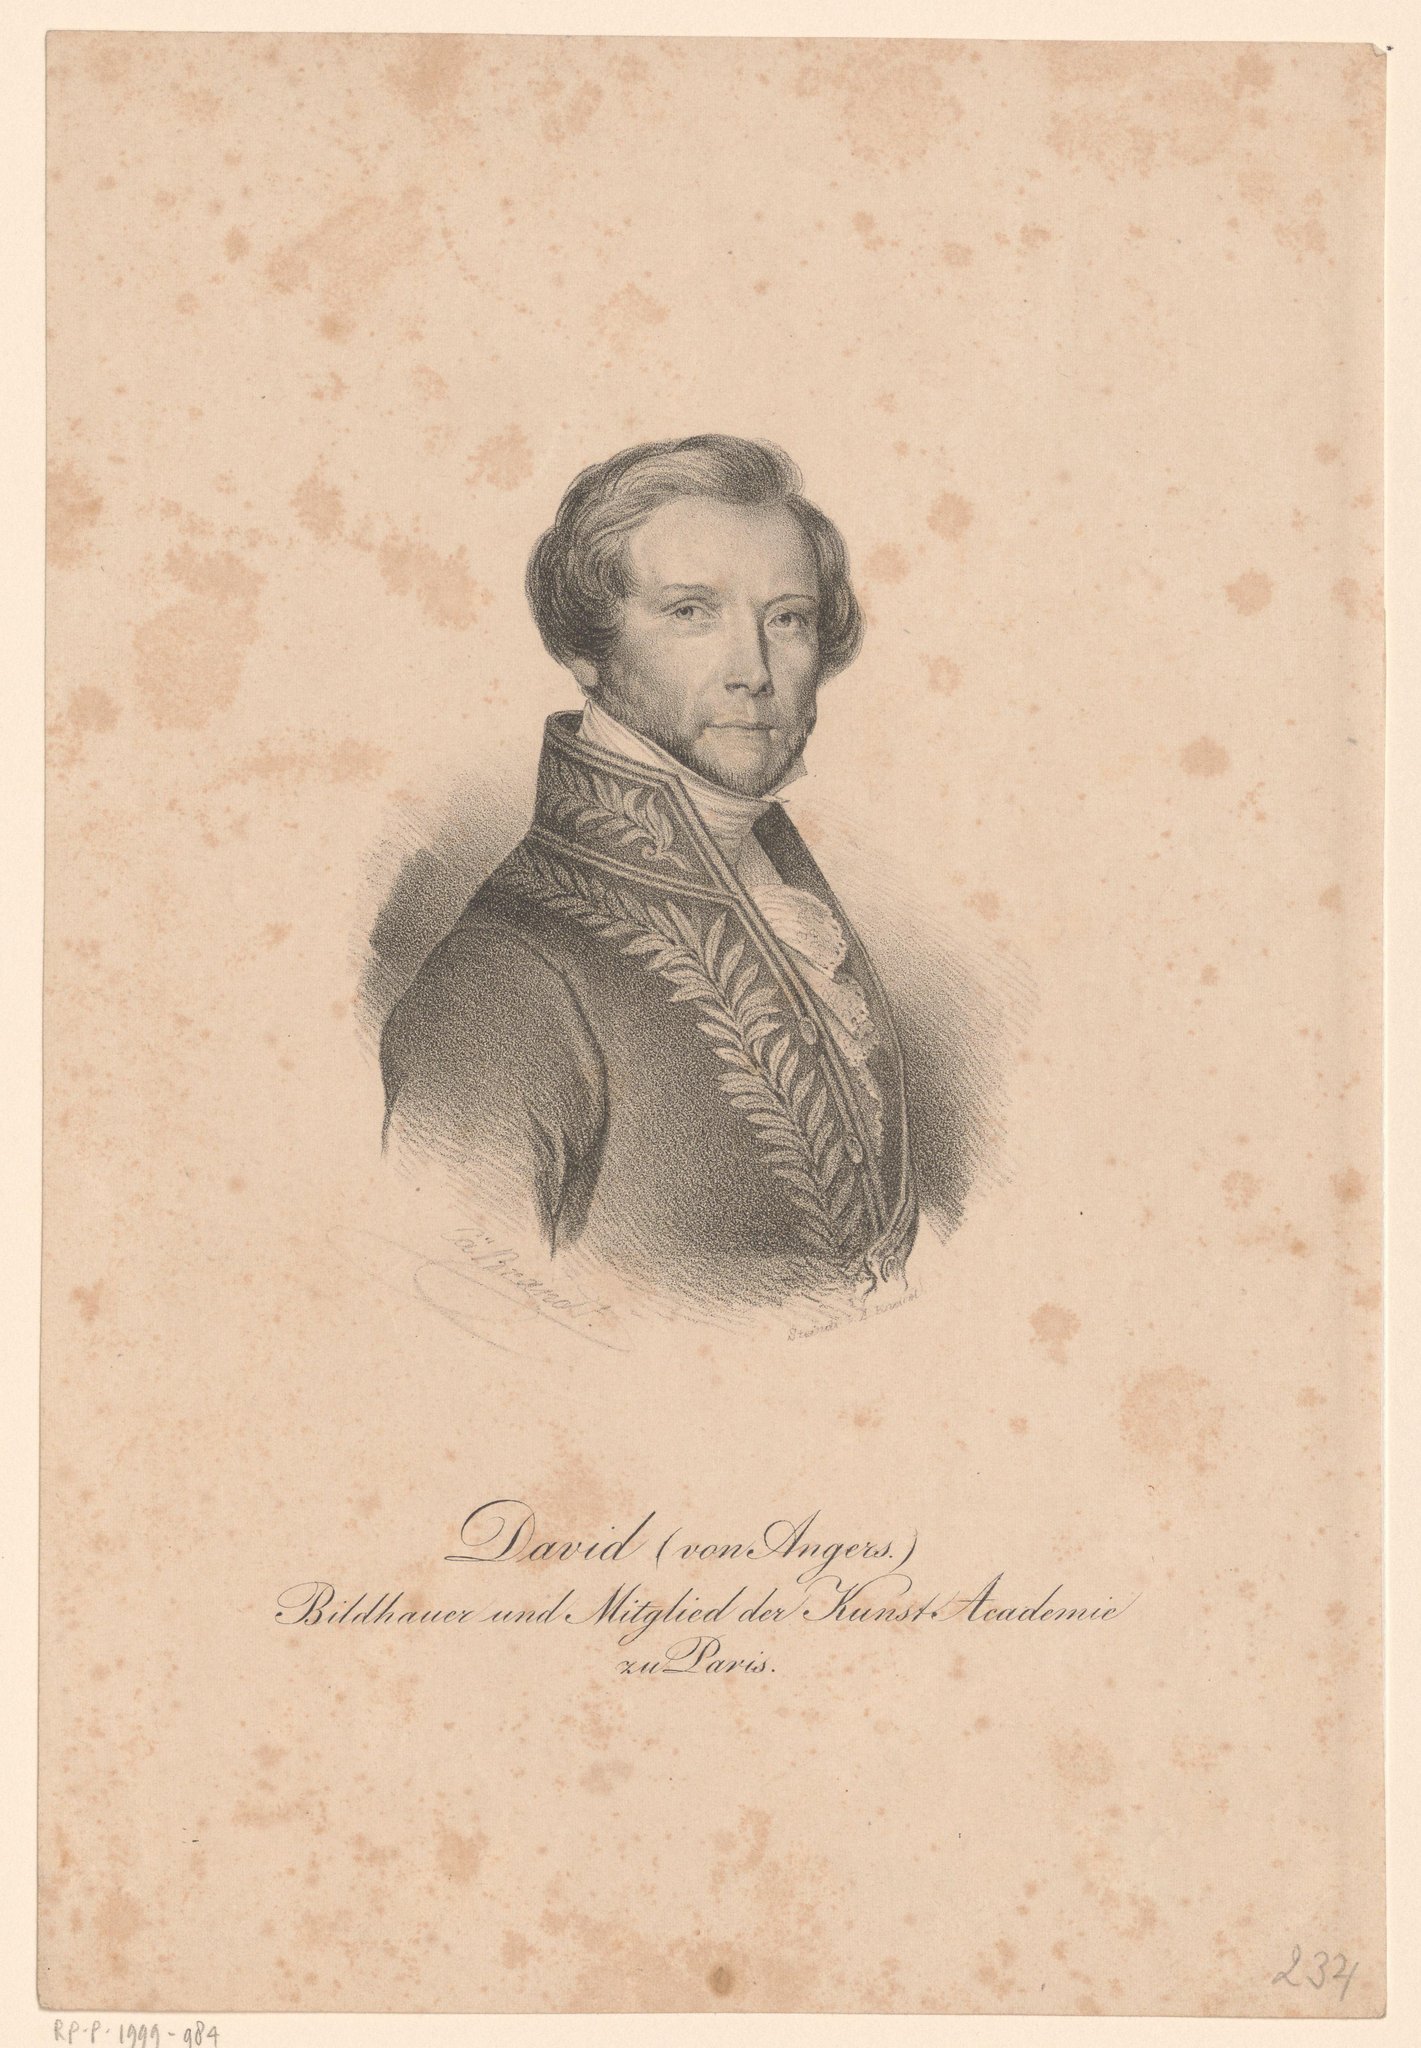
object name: print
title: Portret van David d'Angers, pseudoniem van Pierre-Jean David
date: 1820-1830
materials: paper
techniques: lithograph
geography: leipzig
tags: paris, sculptor, pierre jean david d'angers, portrait, self-portrait of sculptor, historical persons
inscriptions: collector's mark: Lugt 2228, collector's mark: Lugt 2760